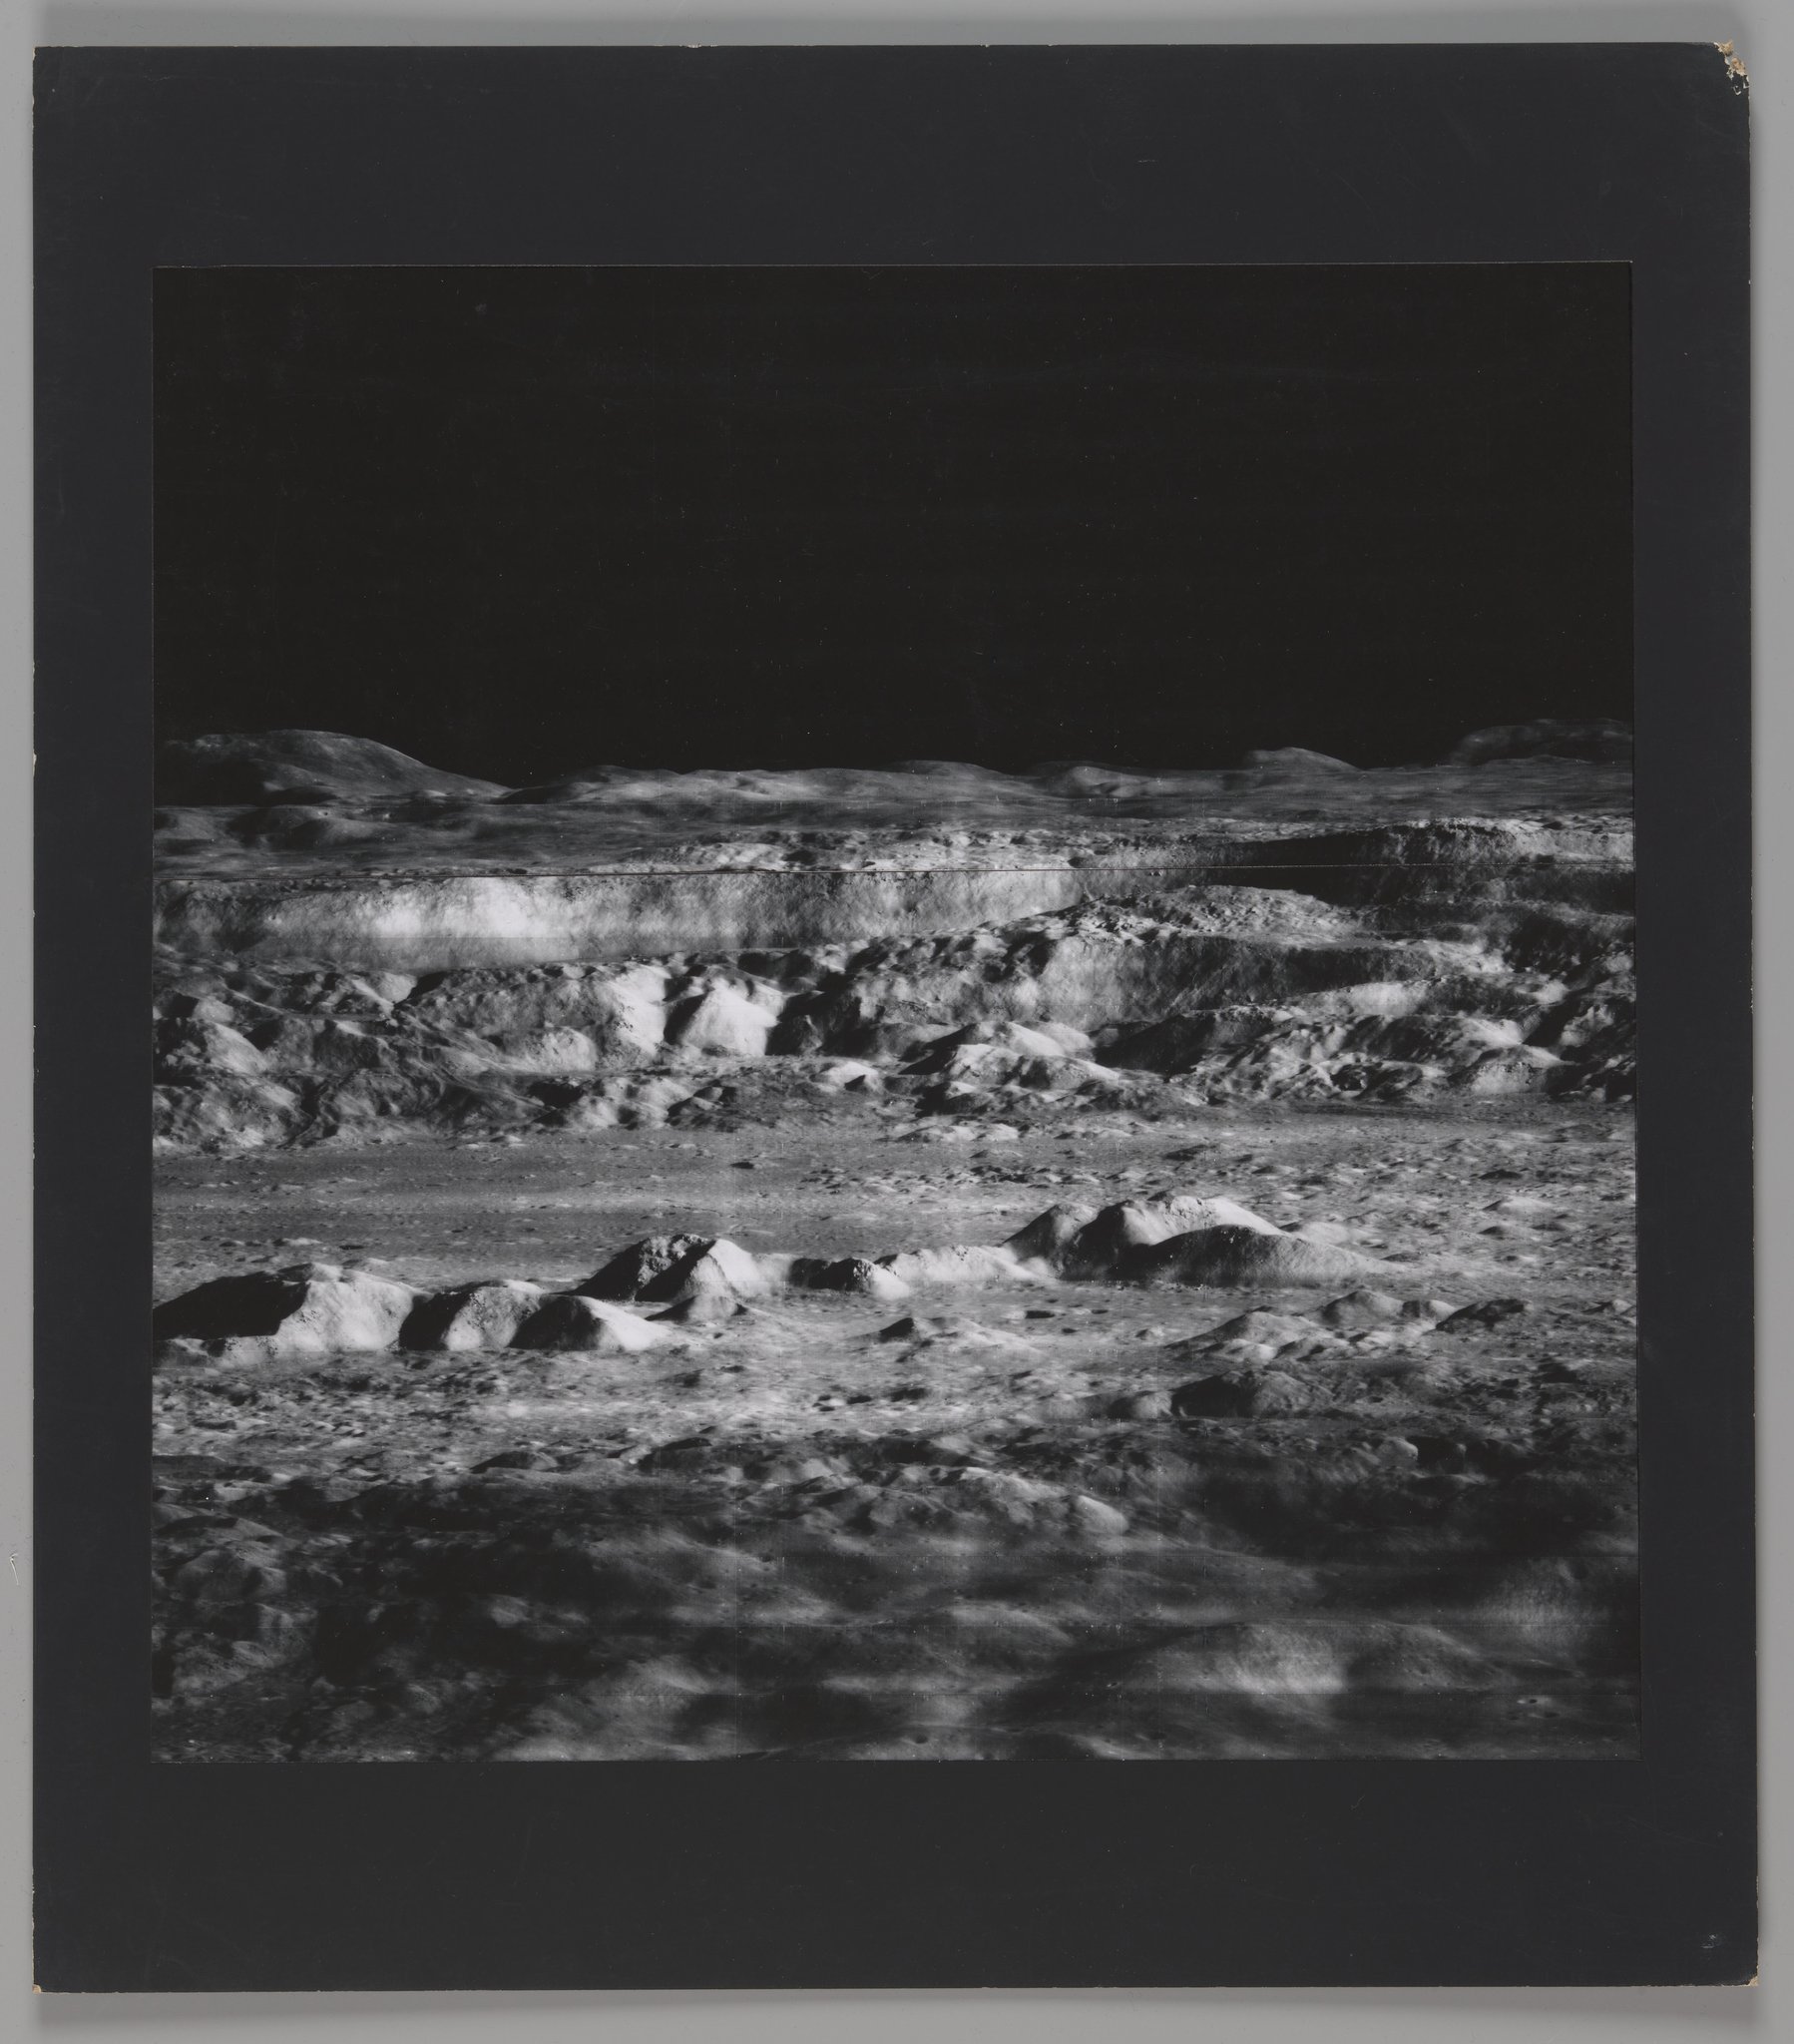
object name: photograph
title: Close-Up of Crater Copernicus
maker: national aeronautics and space administration (nasa)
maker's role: artist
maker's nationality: american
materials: photographic print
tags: moon,astronomy